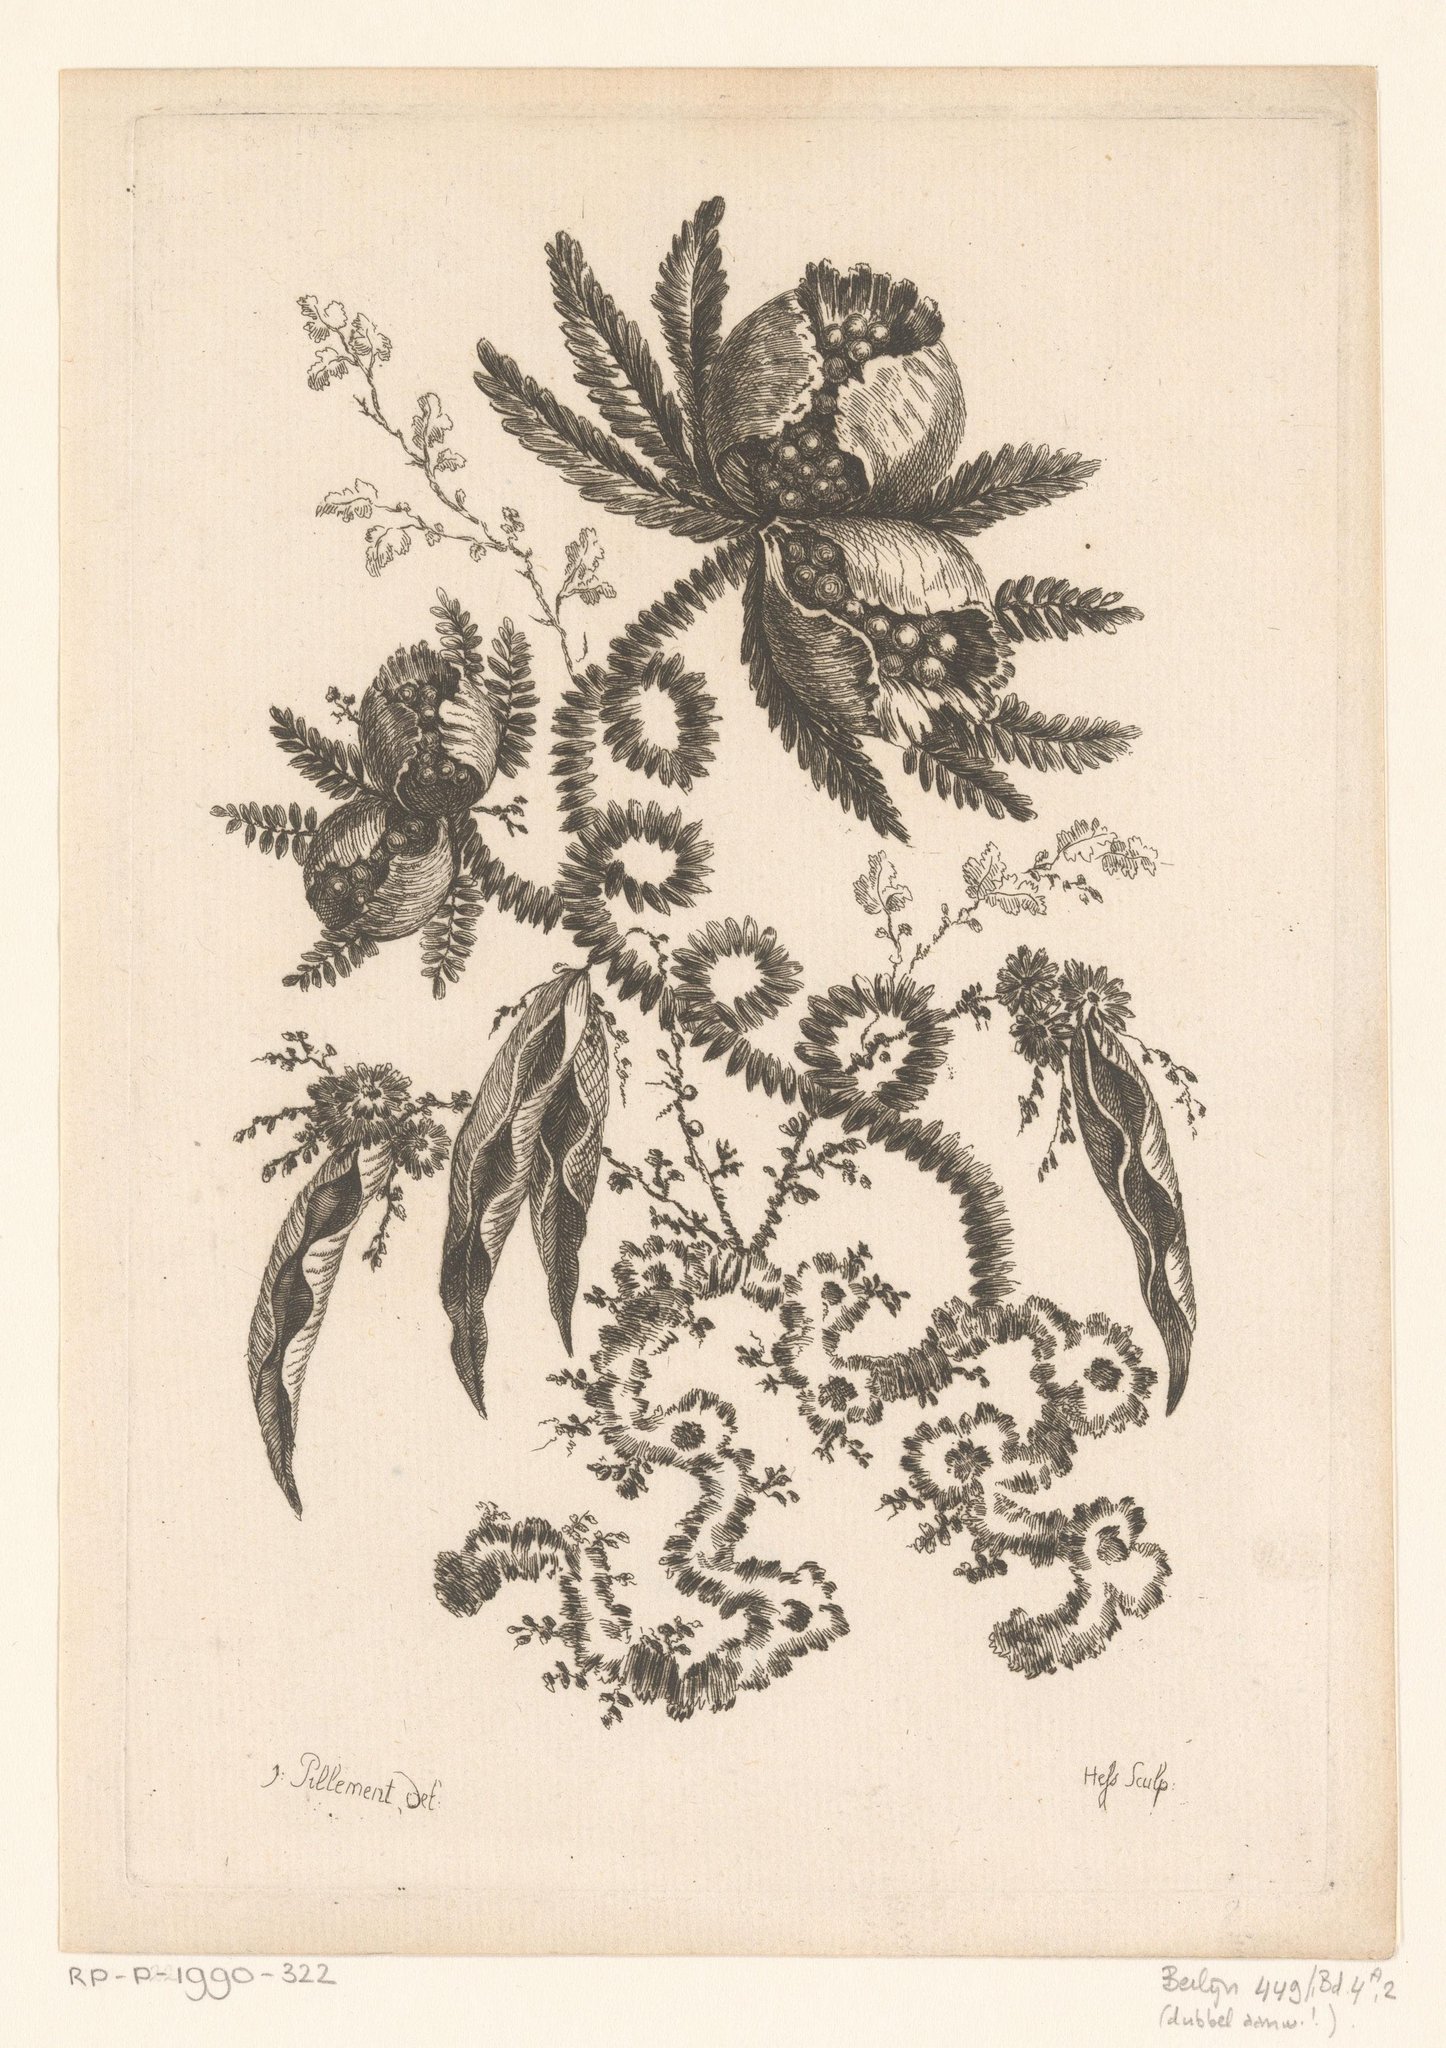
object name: ornament print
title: Fleures Baroque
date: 1755-1775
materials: paper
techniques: etching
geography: paris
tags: flowers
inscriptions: collector's mark: Lugt 2228, collector's mark: Lugt 2760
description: Ronde bloemen met bessen en peulvormige bladeren.